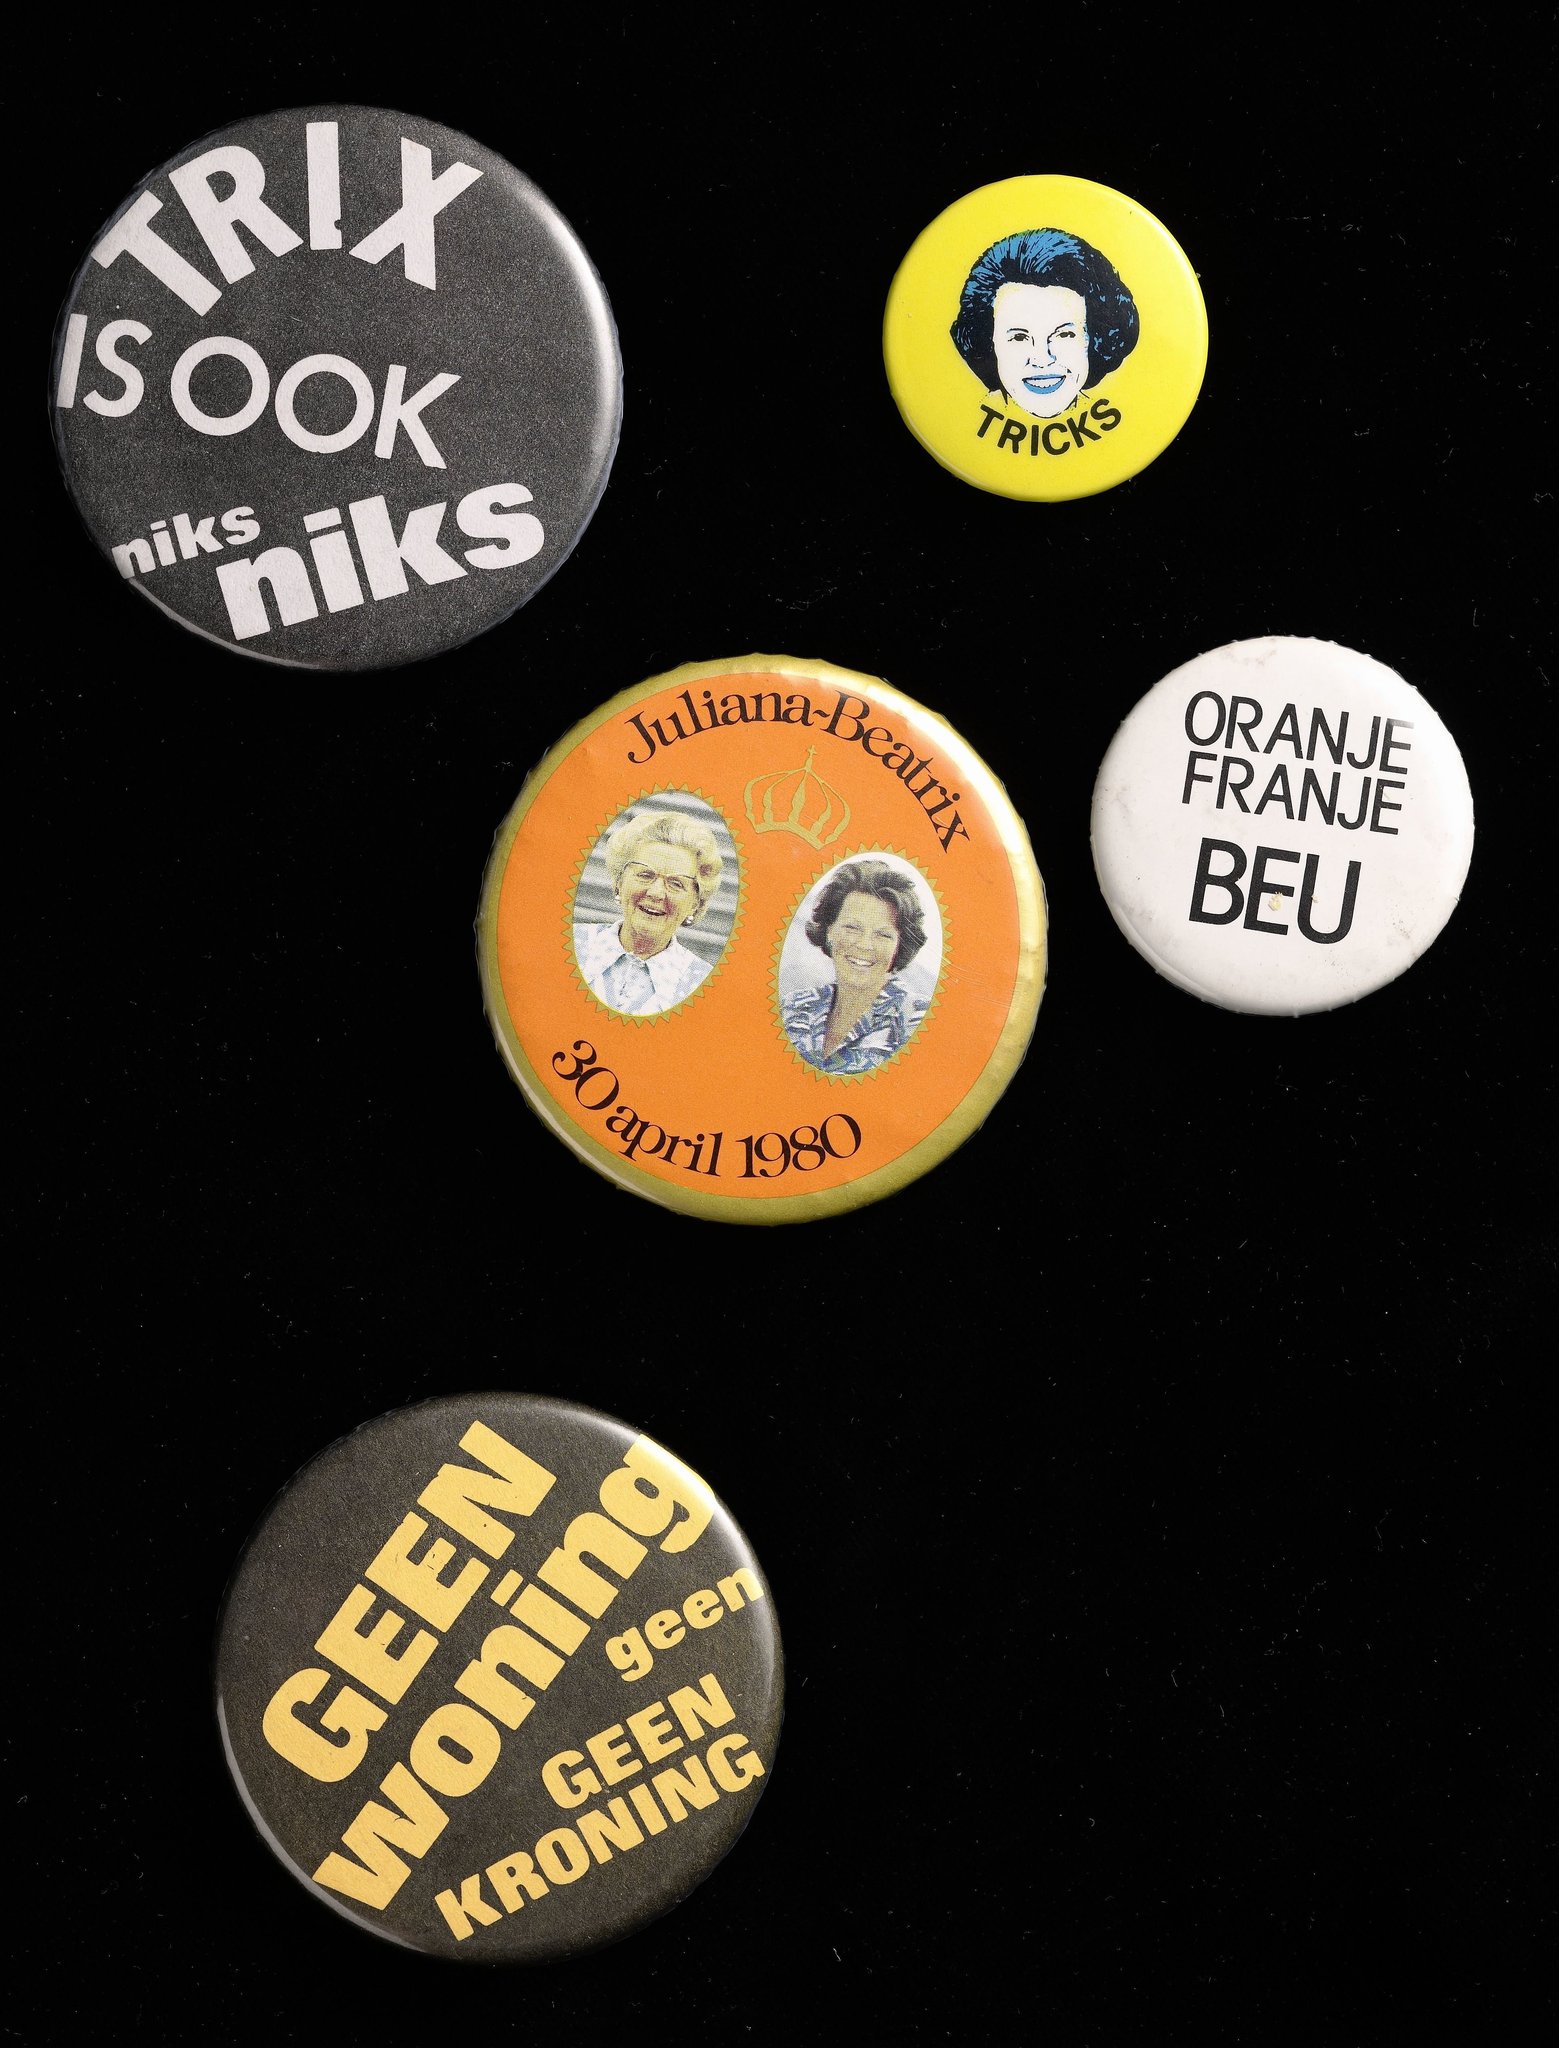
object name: button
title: Button met als opschrift: Trix is ook niks niks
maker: Anonymous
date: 1980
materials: copper, metal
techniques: printing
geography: amsterdam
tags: beatrix (koningin der nederlanden), the hague, juliana of the netherlands, netherlands, inauguration of beatrix as queen of the netherlands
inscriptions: inscription: ‘TRIX IS OOK NIKS NIKS’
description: Zwarte button met witte tekst. Achterzijde button is voorzien van een speld.